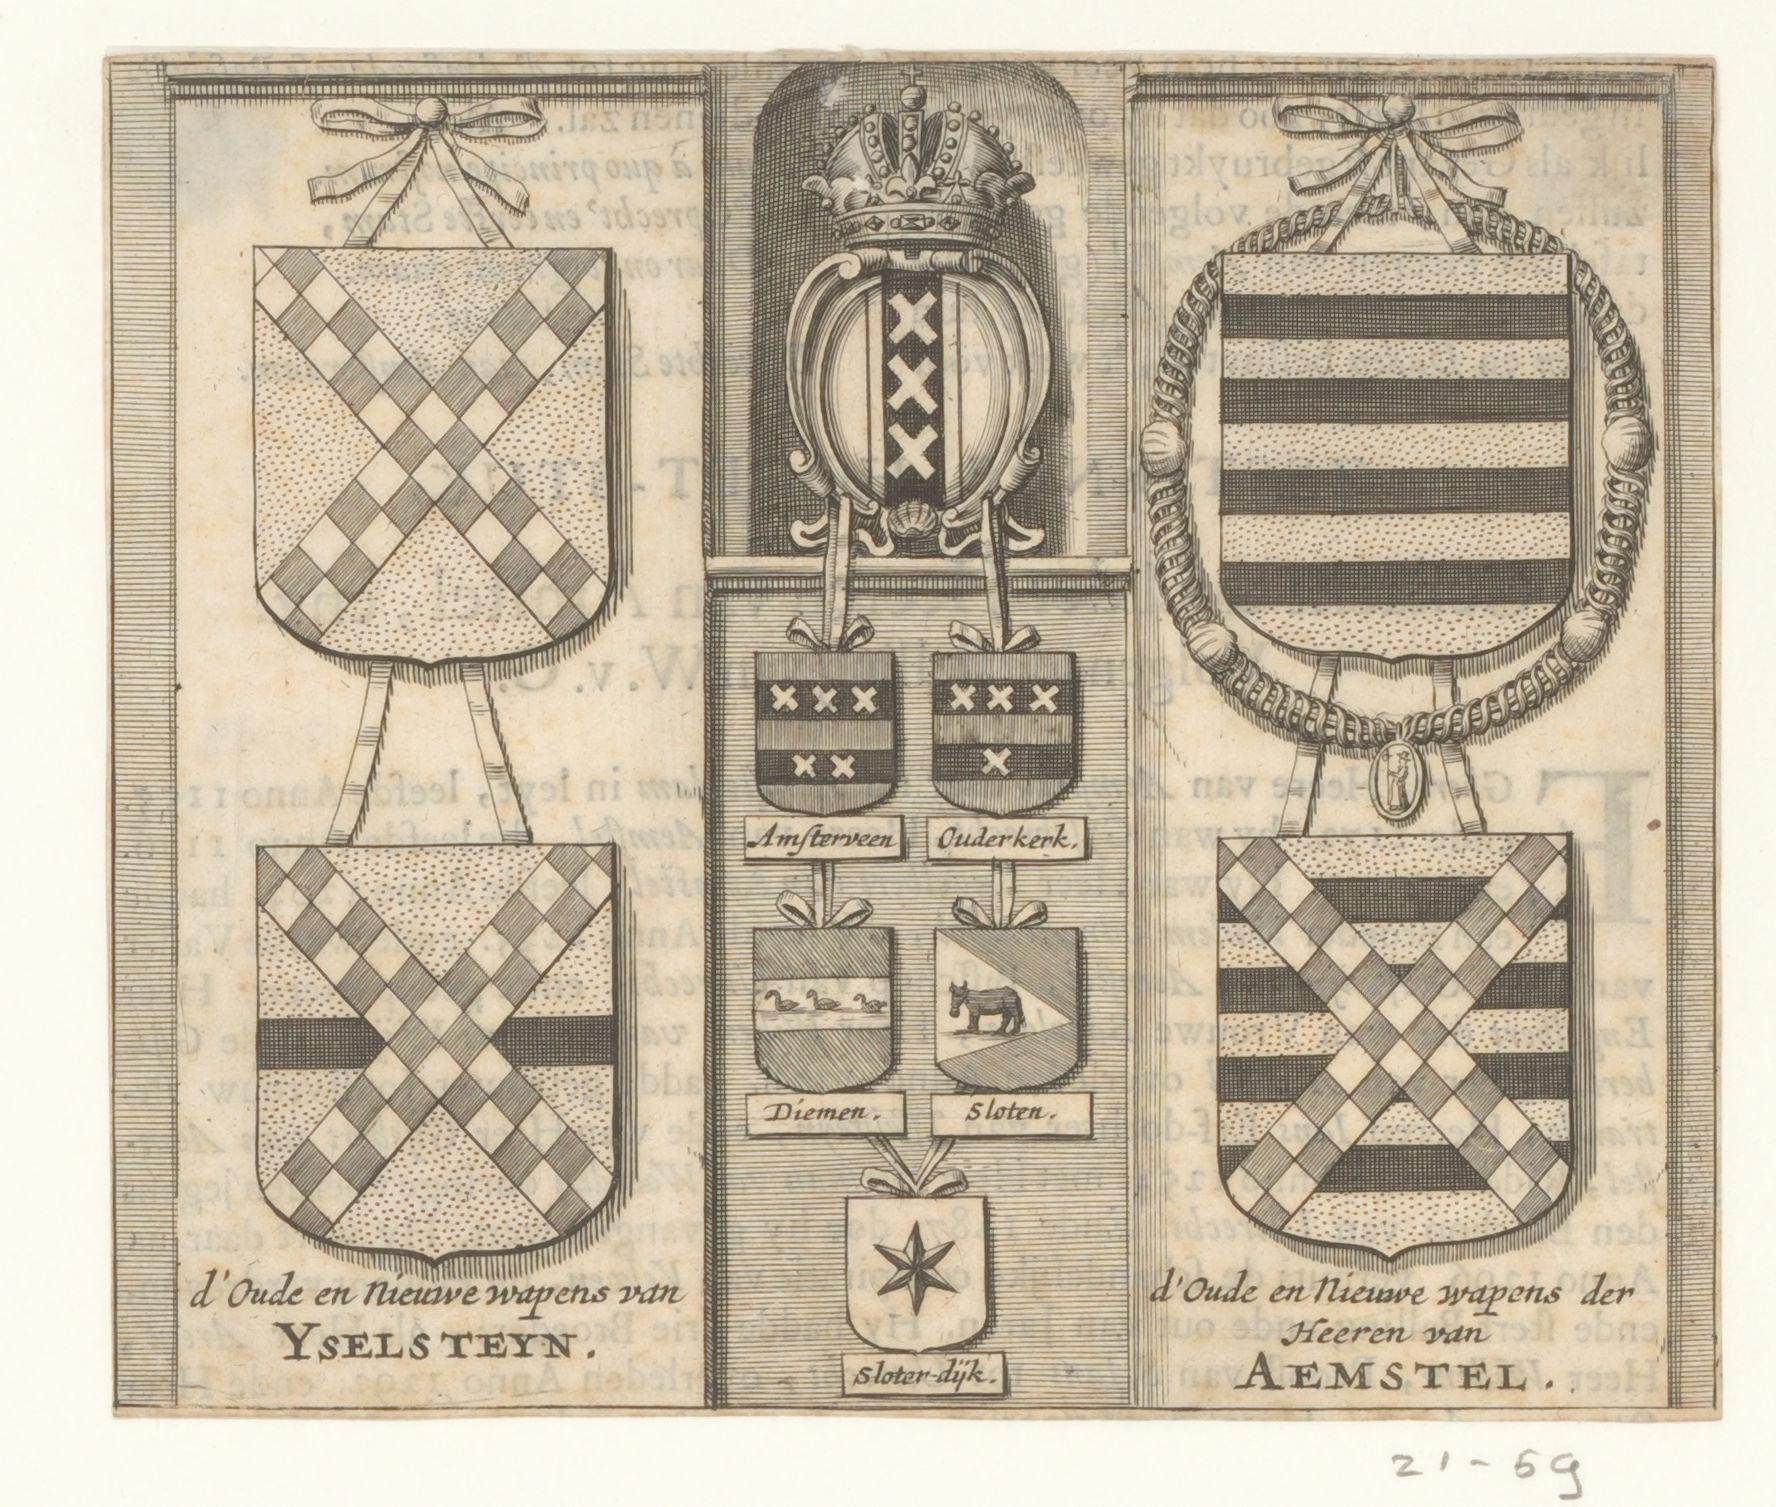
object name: book illustration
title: Tien verschillende wapens van IJsselstein, Amsterdam en de heren van Amstel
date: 1693-1694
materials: paper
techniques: etching, letterpress printing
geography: amsterdam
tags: coat of arms (as symbol of the state, etc.) (+ city; municipal), device (as symbol of the state, etc.), armorial bearing, heraldry, amsterdam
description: Prent uit: Commelin, Caspar. Beschryvinge van Amsterdam, desselfs eerste oorspronk uyt den Huyse der Heeren van Aemstel (…). 2 delen. Amsterdam: Abraham Wolfgang et al, 1693, dl. 2, p. 128.